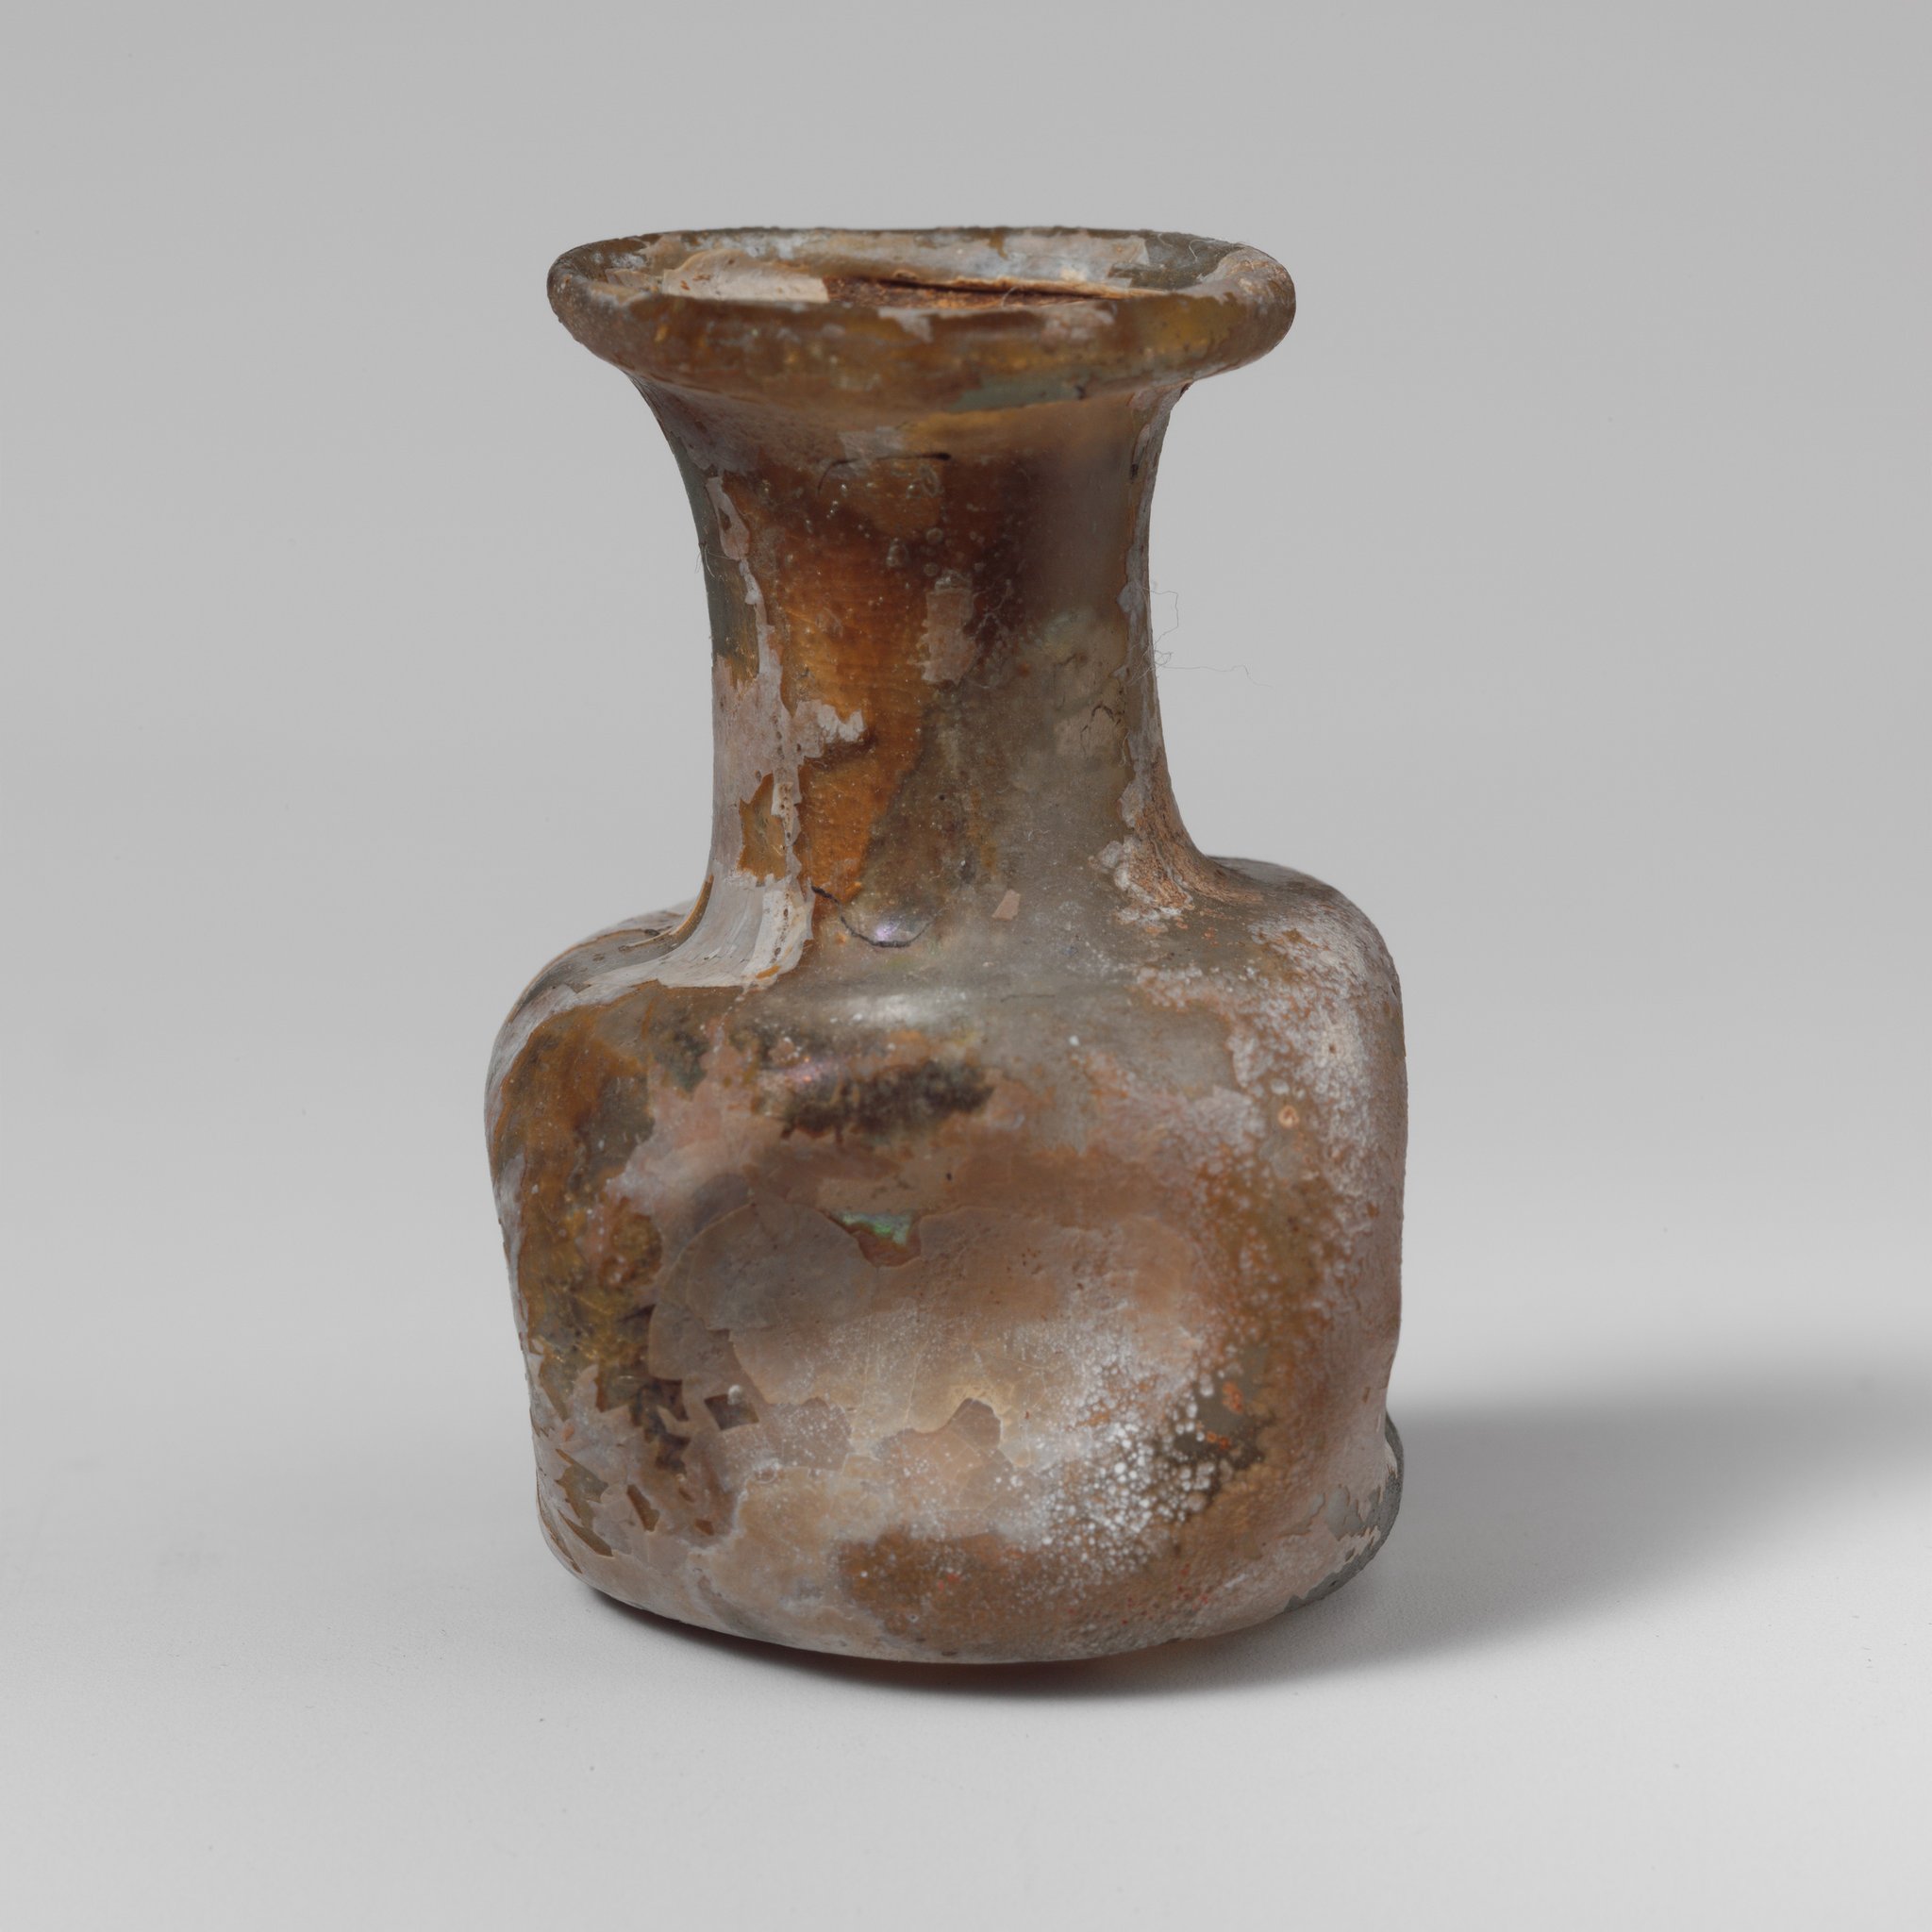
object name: bottle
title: Glass perfume bottle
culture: roman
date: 101-300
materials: glass